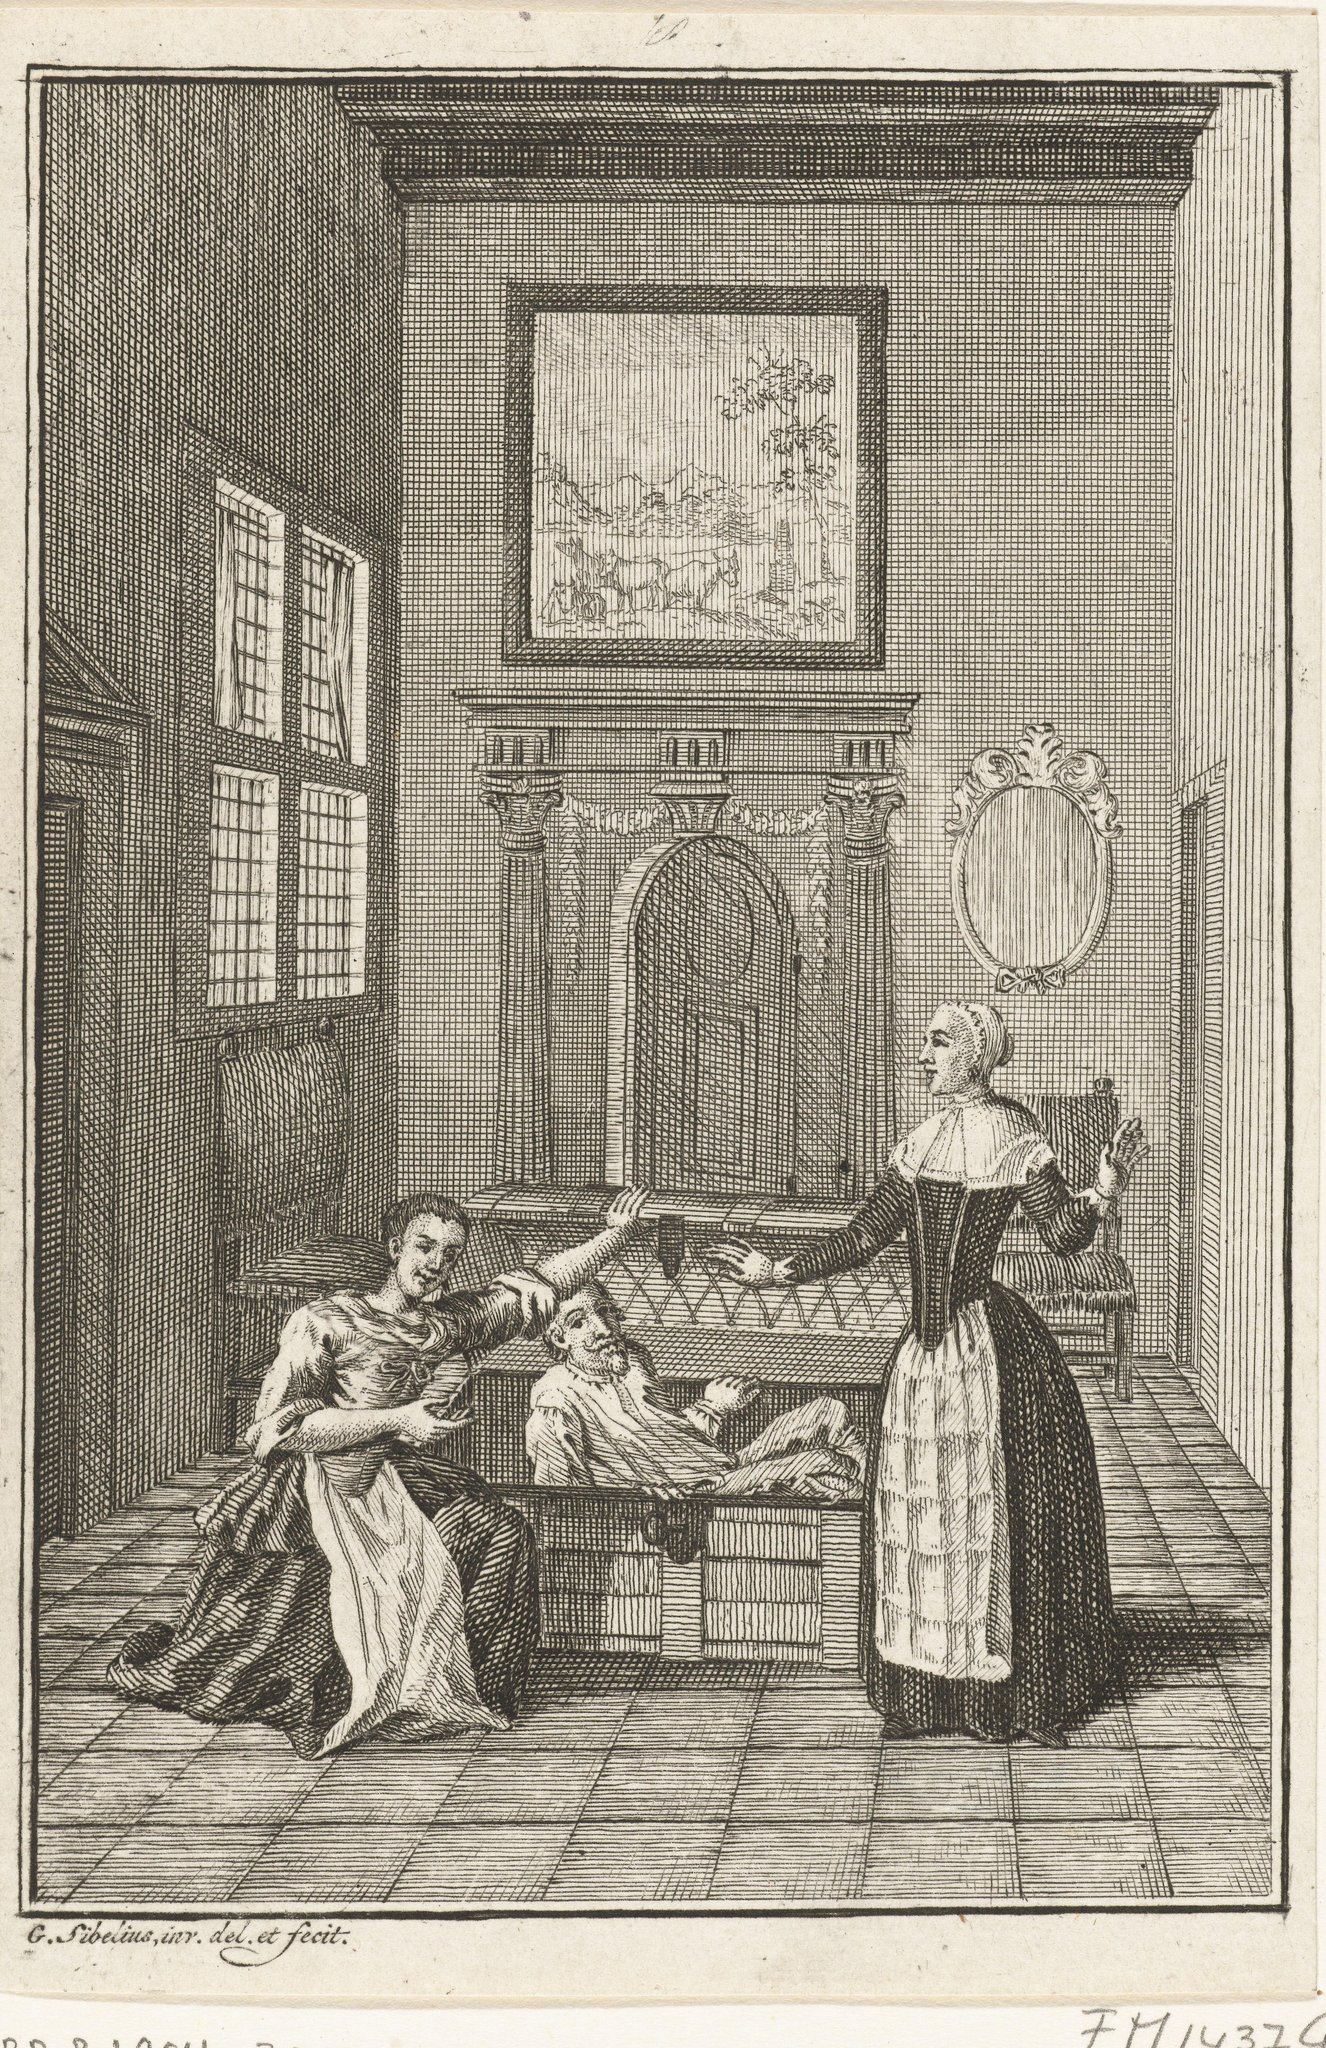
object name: history print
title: De vlucht van Hugo de Groot uit Loevestein, 1621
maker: gerard sibelius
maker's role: print maker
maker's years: 1734-1785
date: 1768-1771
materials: paper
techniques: etching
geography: northern netherlands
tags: delft, hugo de groot, the hague, law and jurisprudence (+ escape from prison), loevestein castle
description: Dienstmeid Elsje van Houweningen betrapt Hugo de Groot die, geholpen door zijn vrouw Maria van Reigersberch, de boekenkist uitprobeert, maart 1621. Van Reigersberch had het plan voor de ontsnapping met de boekenkist bedacht en Van Houweningen zou een grote rol spelen in de uiteindelijke uitvoering ervan.